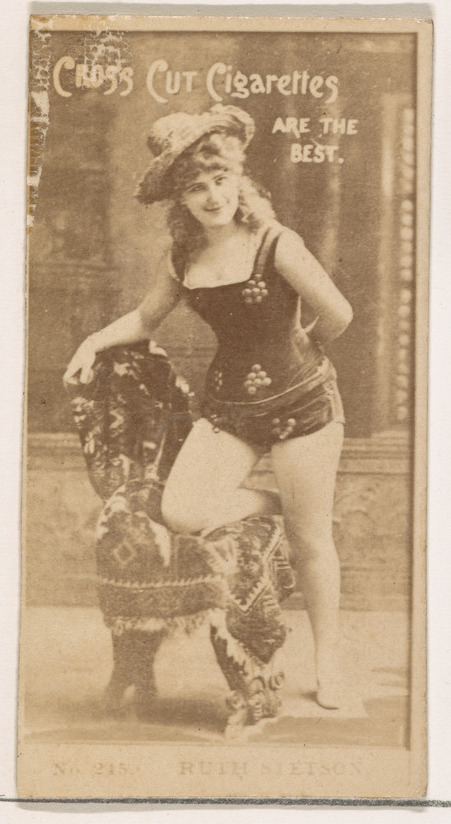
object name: print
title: Card Number 245, Ruth Stetson, from the Actors and Actresses series (N145-2) issued by Duke Sons & Co. to promote Cross Cut Cigarettes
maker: w. duke, sons & co.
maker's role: publisher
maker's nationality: american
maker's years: 1870-1920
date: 1880-1889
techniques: albumen silver print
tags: portraits,women,actresses